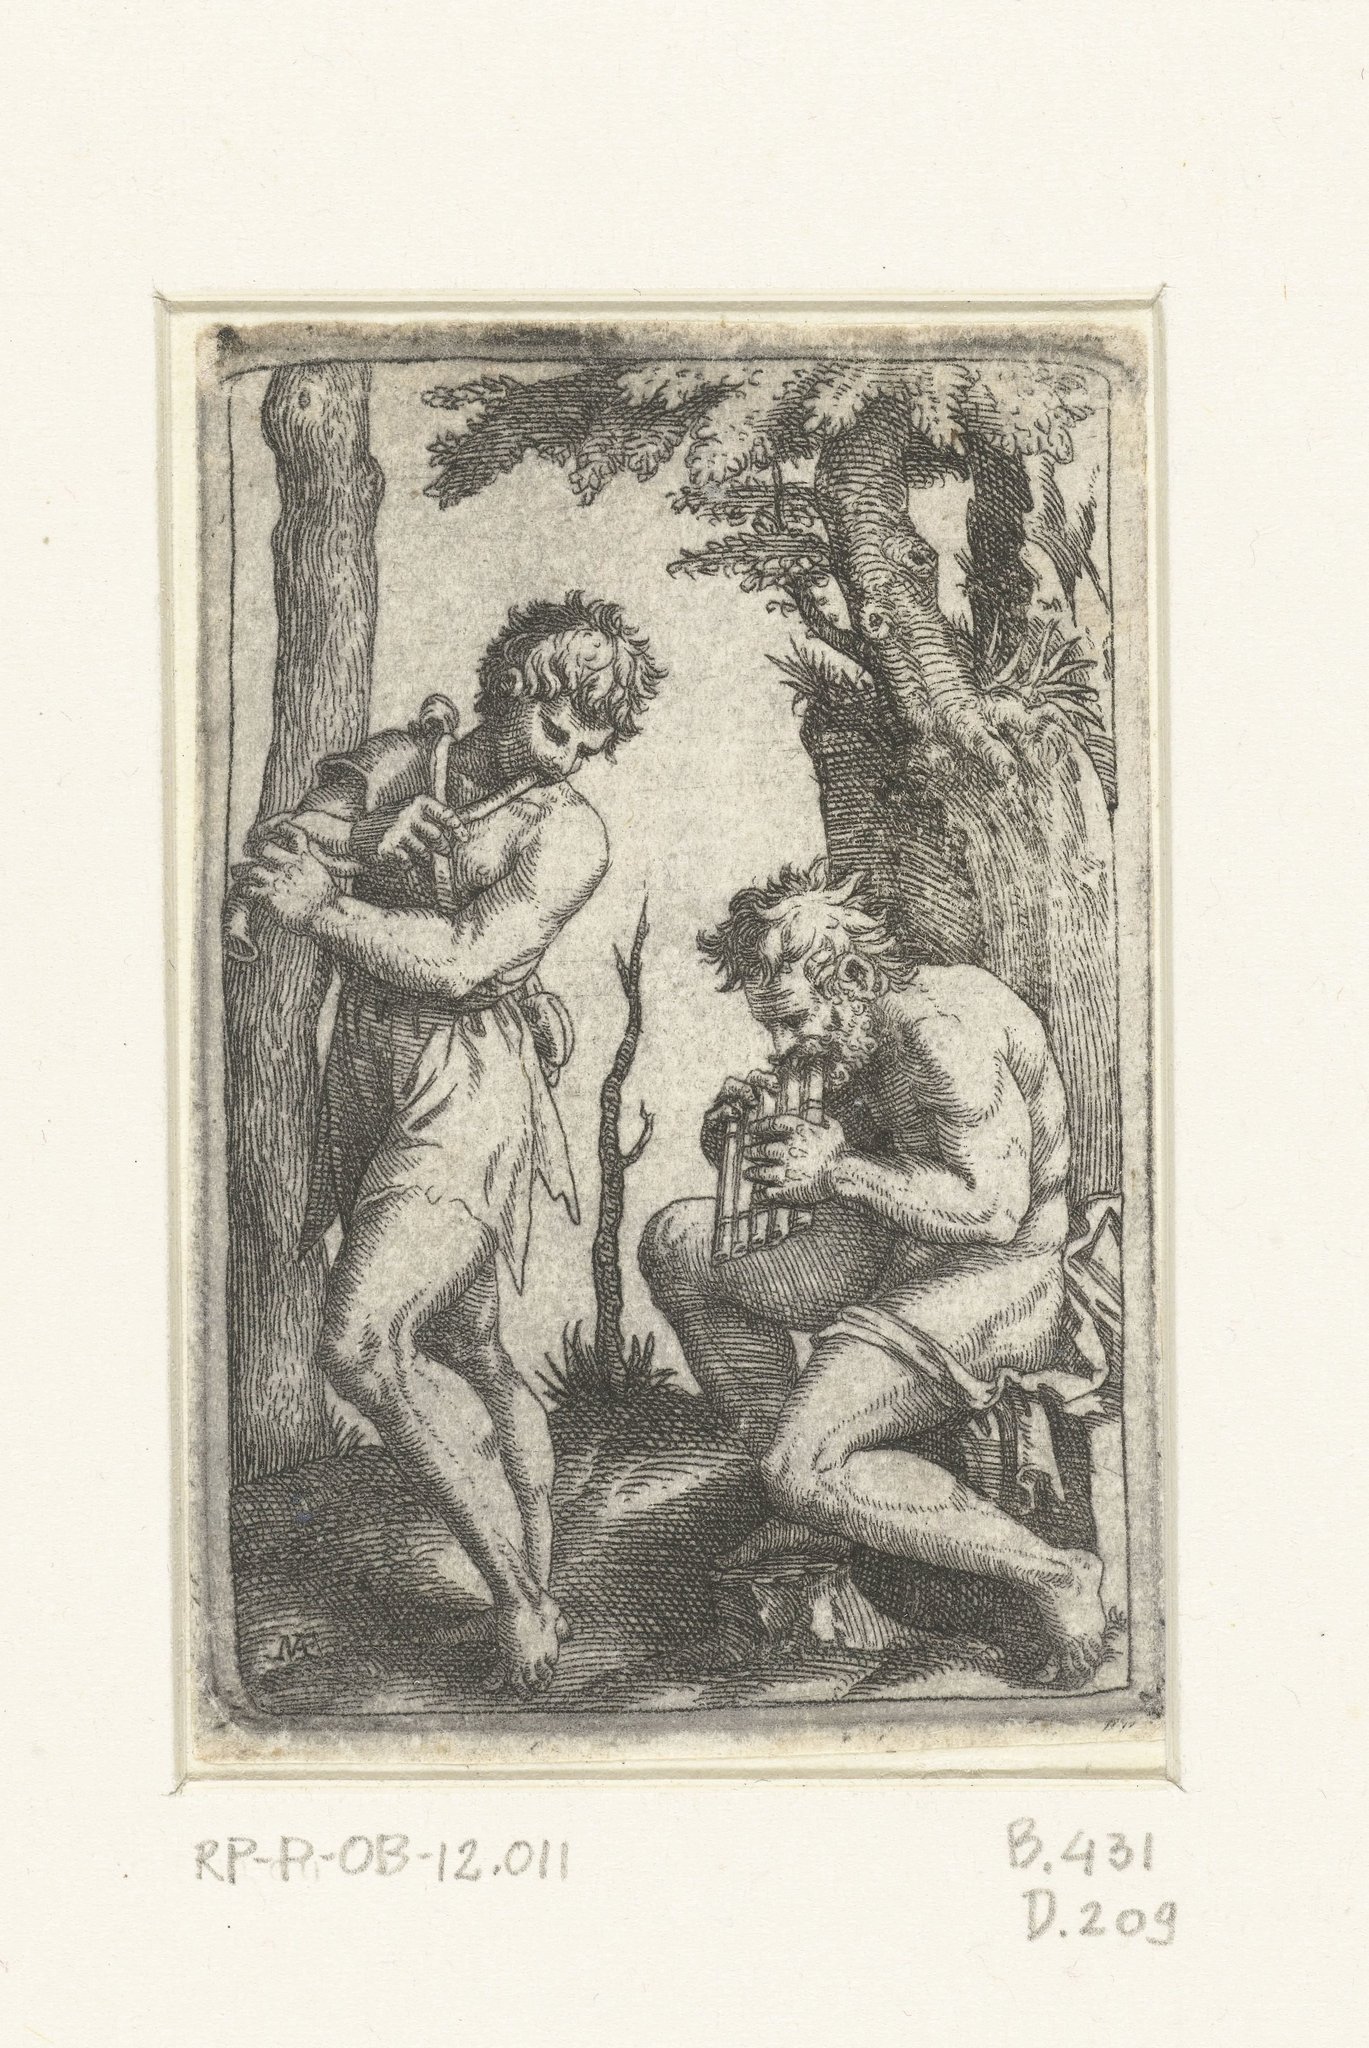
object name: print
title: Jonge herder met schalmei en oude herder met panfluit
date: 1510-1527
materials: paper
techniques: engraving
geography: italy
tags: panpipes, herding, herdsman, herdswoman, shepherd, shepherdess, cowherd, etc.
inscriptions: collector's mark: Lugt 12, collector's mark: ‘F Rechberger 1802’ Lugt 2133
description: Prent mogelijk naar ontwerp van Marcantonio Raimondi.